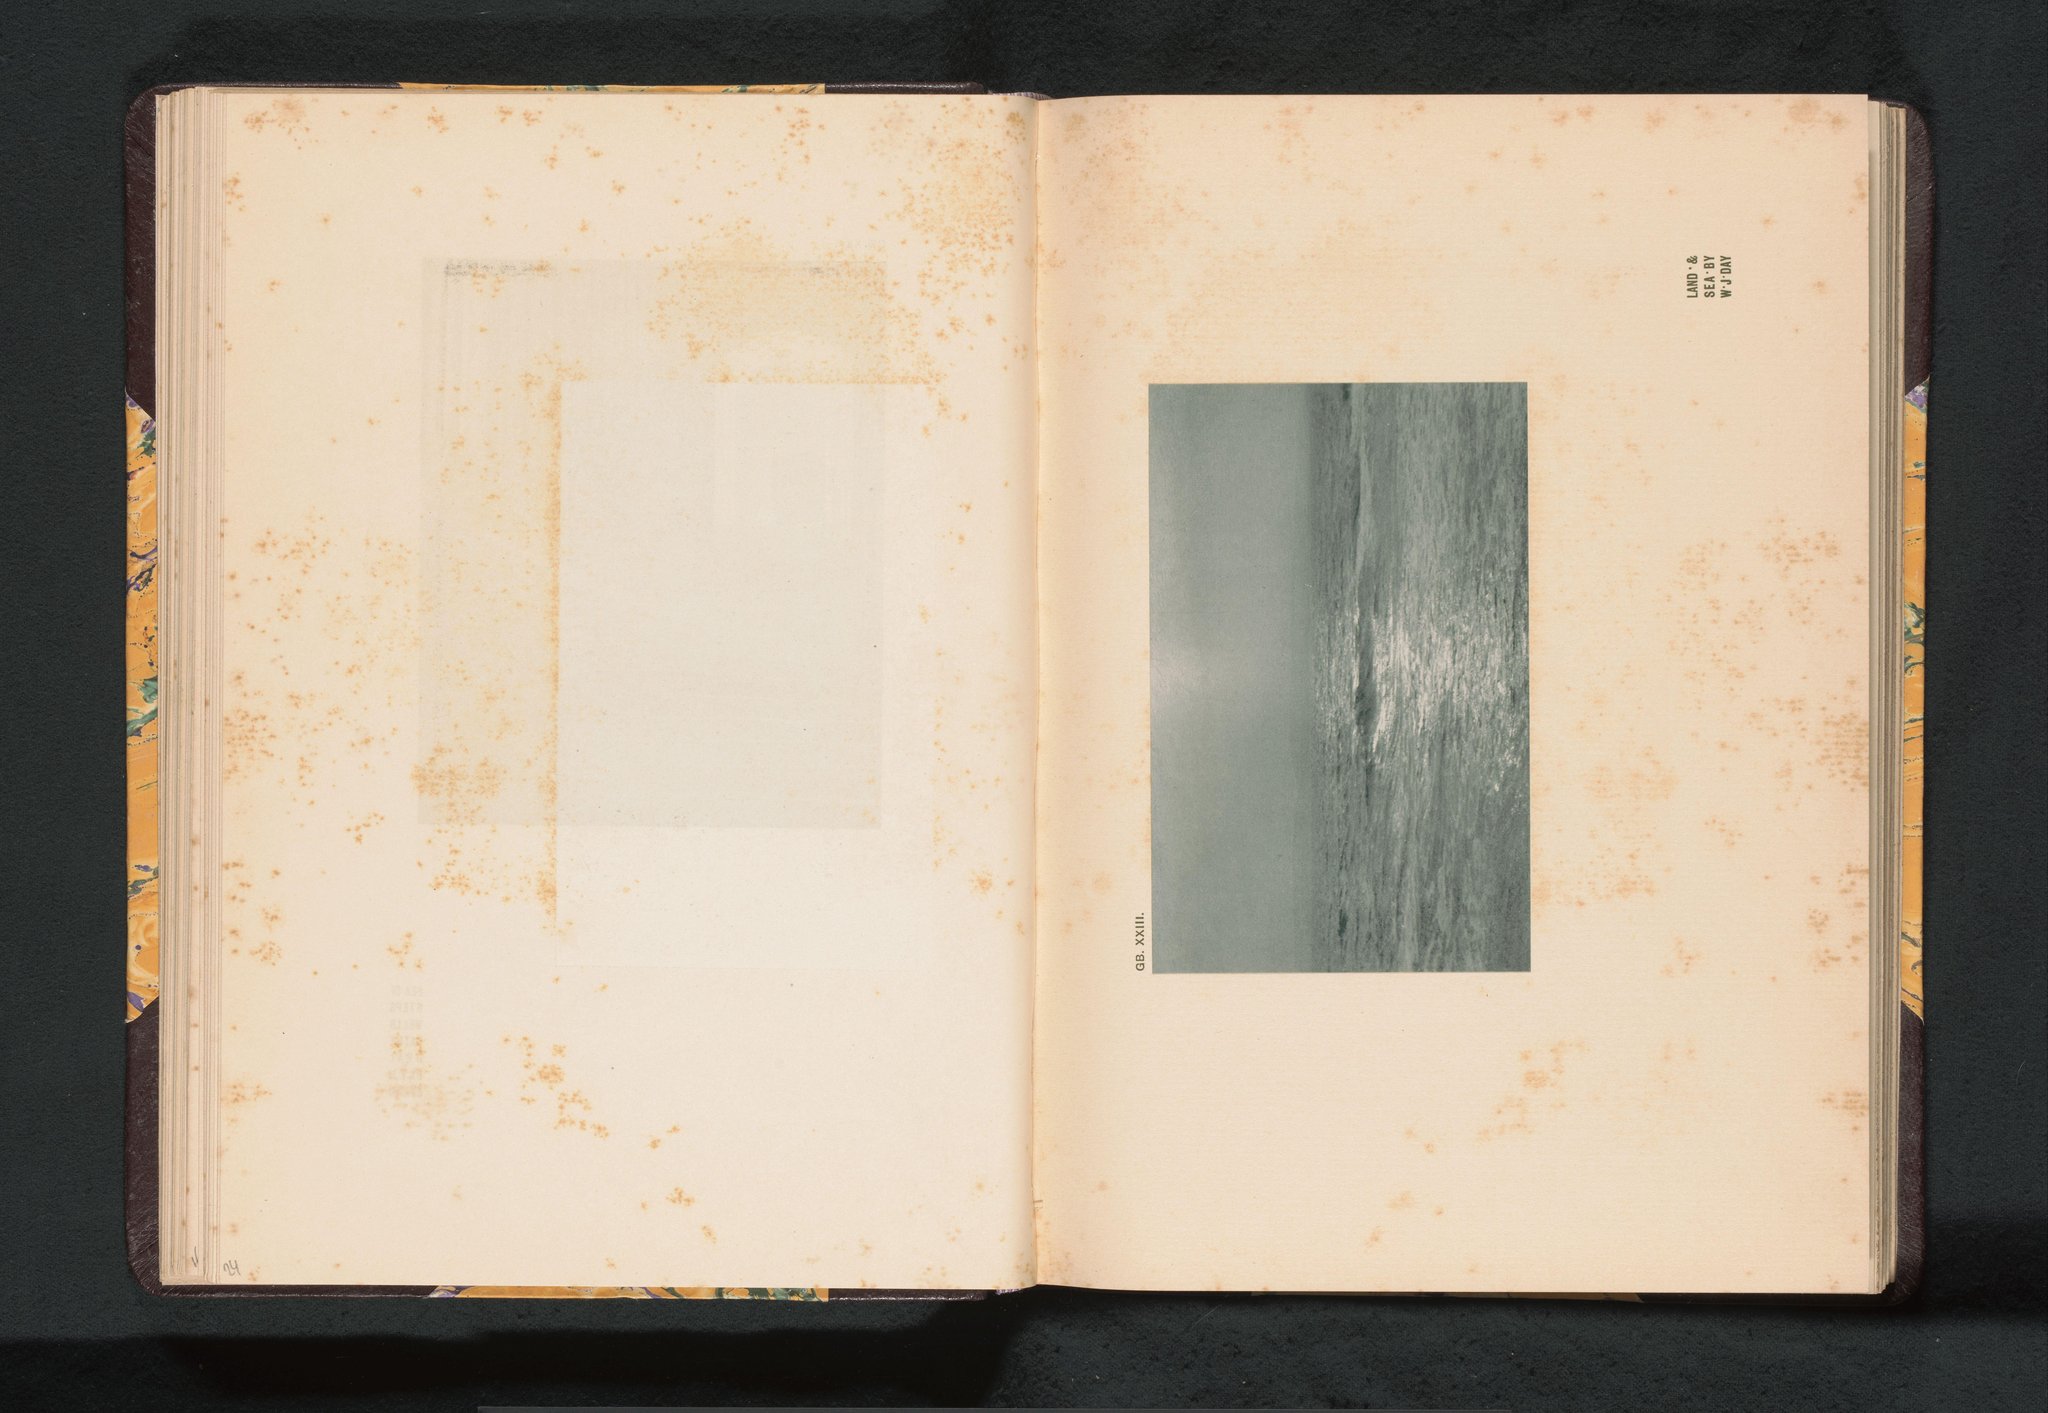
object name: photomechanical print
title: Zeegezicht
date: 1900-1905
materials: paper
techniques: autotype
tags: sea (seascape)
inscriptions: inscription: ‘GB. XXIII.’, inscription: ‘Land & sea by W.J. Day’